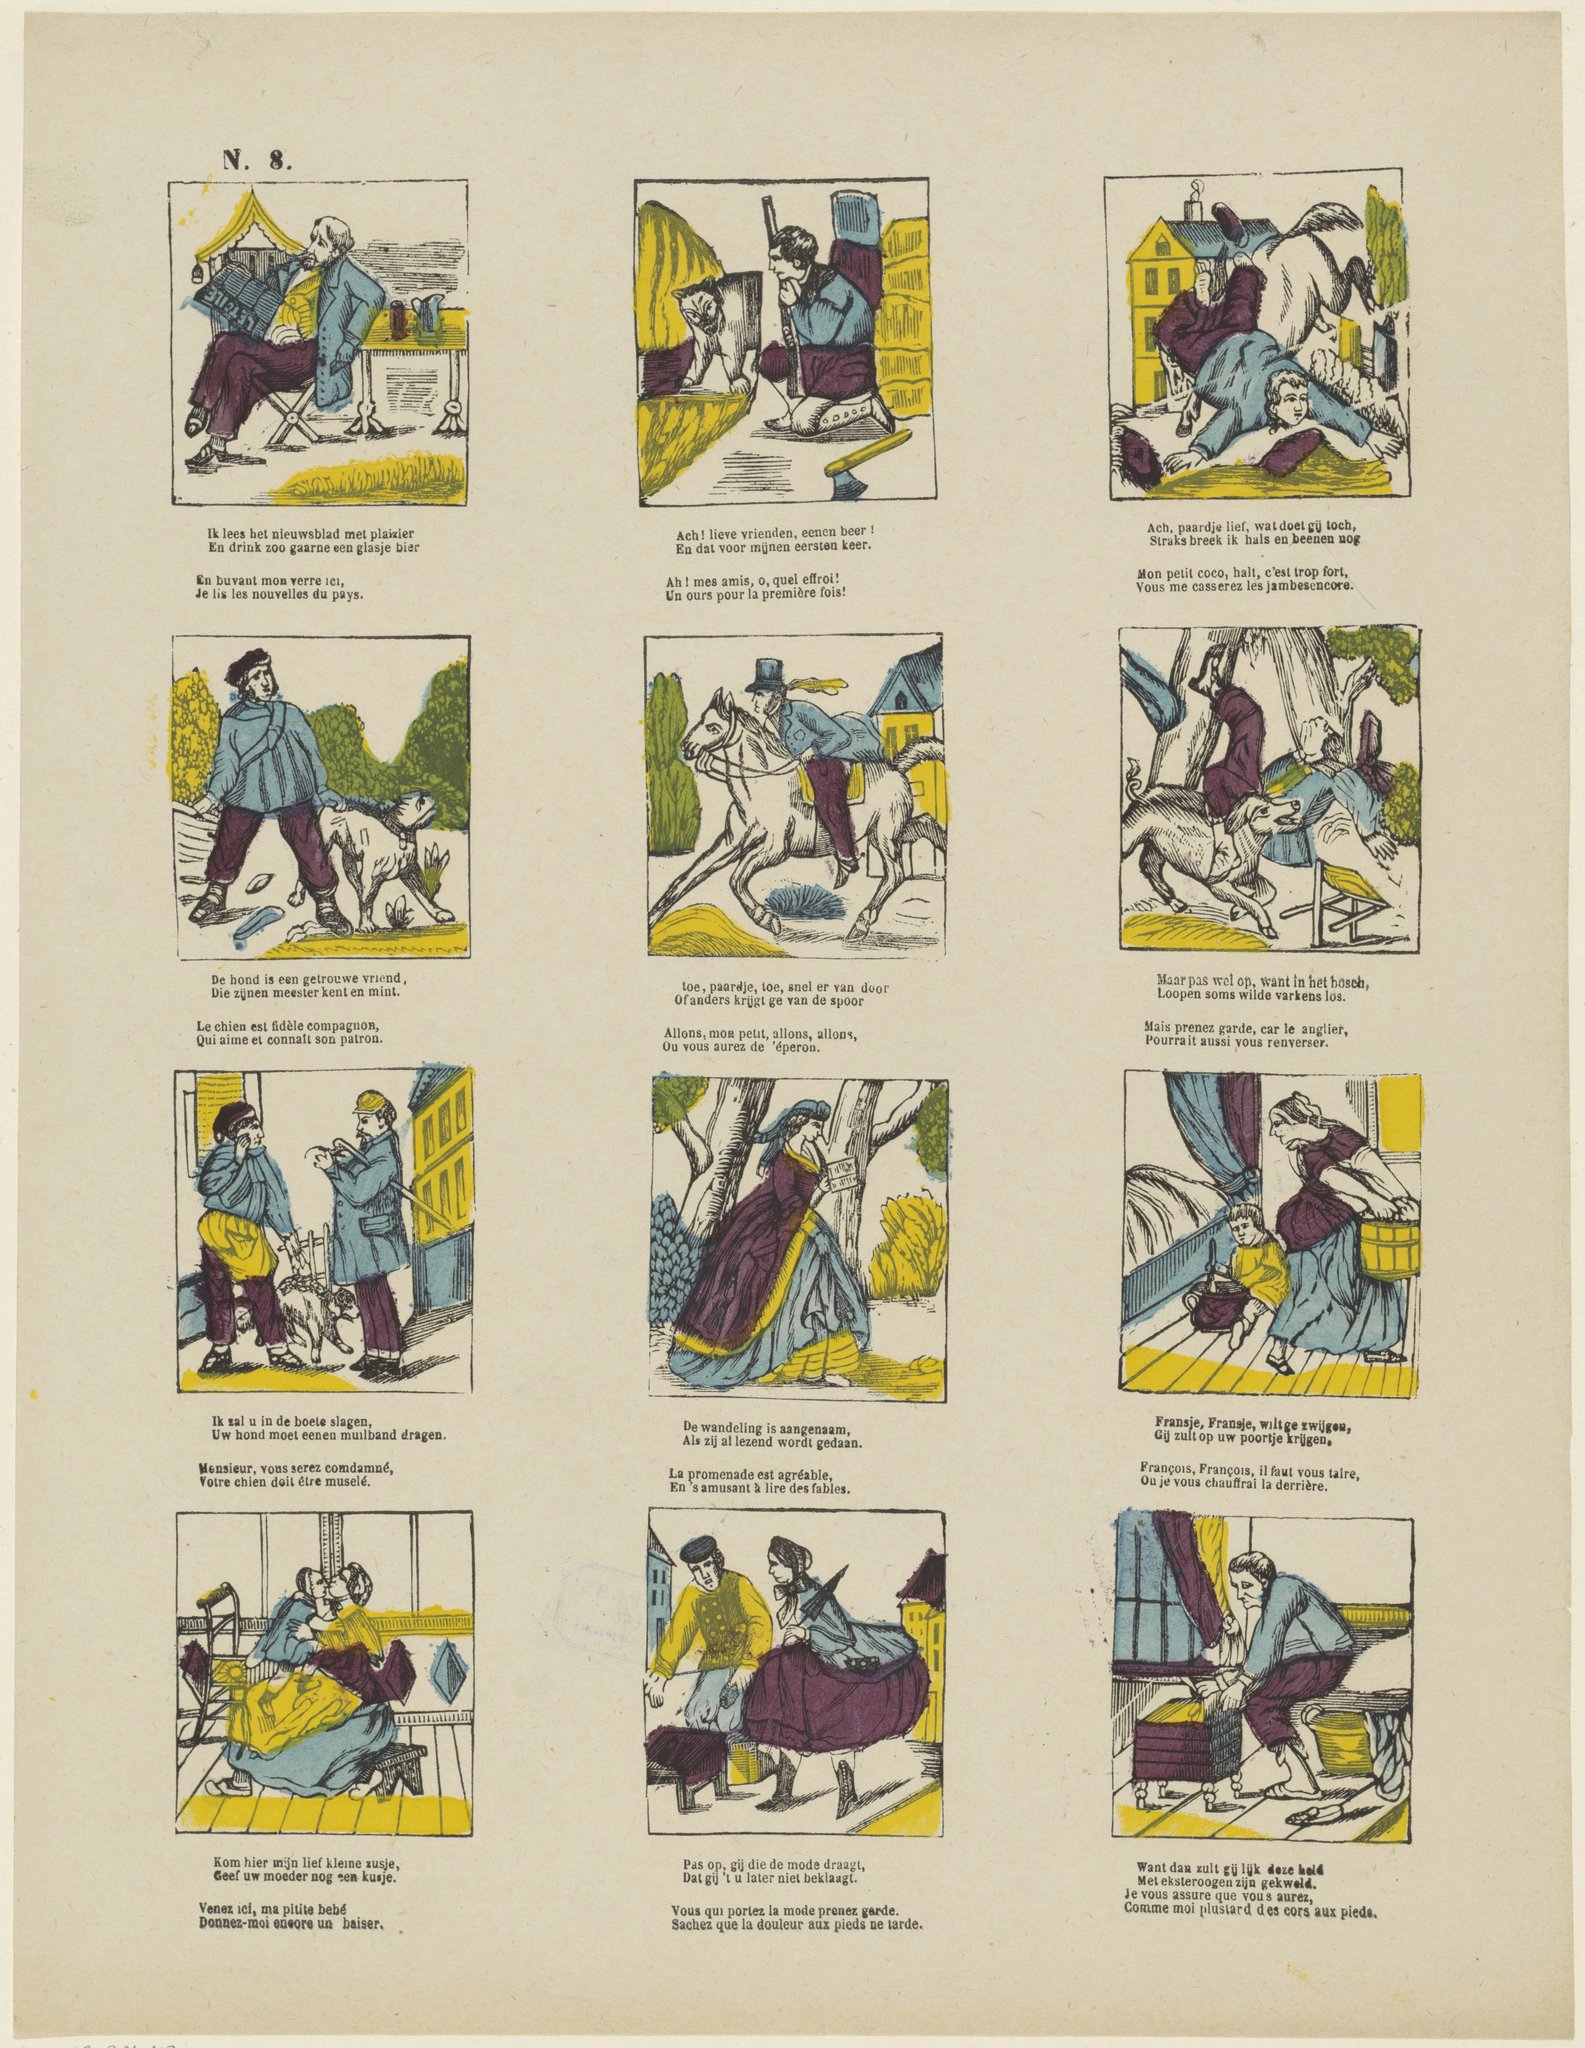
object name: print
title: Verschillende voorstellingen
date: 1866-1902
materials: paper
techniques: colour, letterpress printing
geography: turnhout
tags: riding a horse, ass, or mule; rider, horseman, walking, hiking (recreation), reading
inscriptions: collector's mark: ‘Edw. Ipers / Oever 27, / Antwerpen.’, collector's mark: Lugt 2760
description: Blad met 12 voorstellingen van verschillende aard, waaronder voorstellingen van een man die de krant leest, een man te paard en een vrouw die al lezend een wandeling maakt. Onder elke voorstelling een tweeregelig vers in het Nederlands en in het Frans. Genummerd linksboven: N. 8.